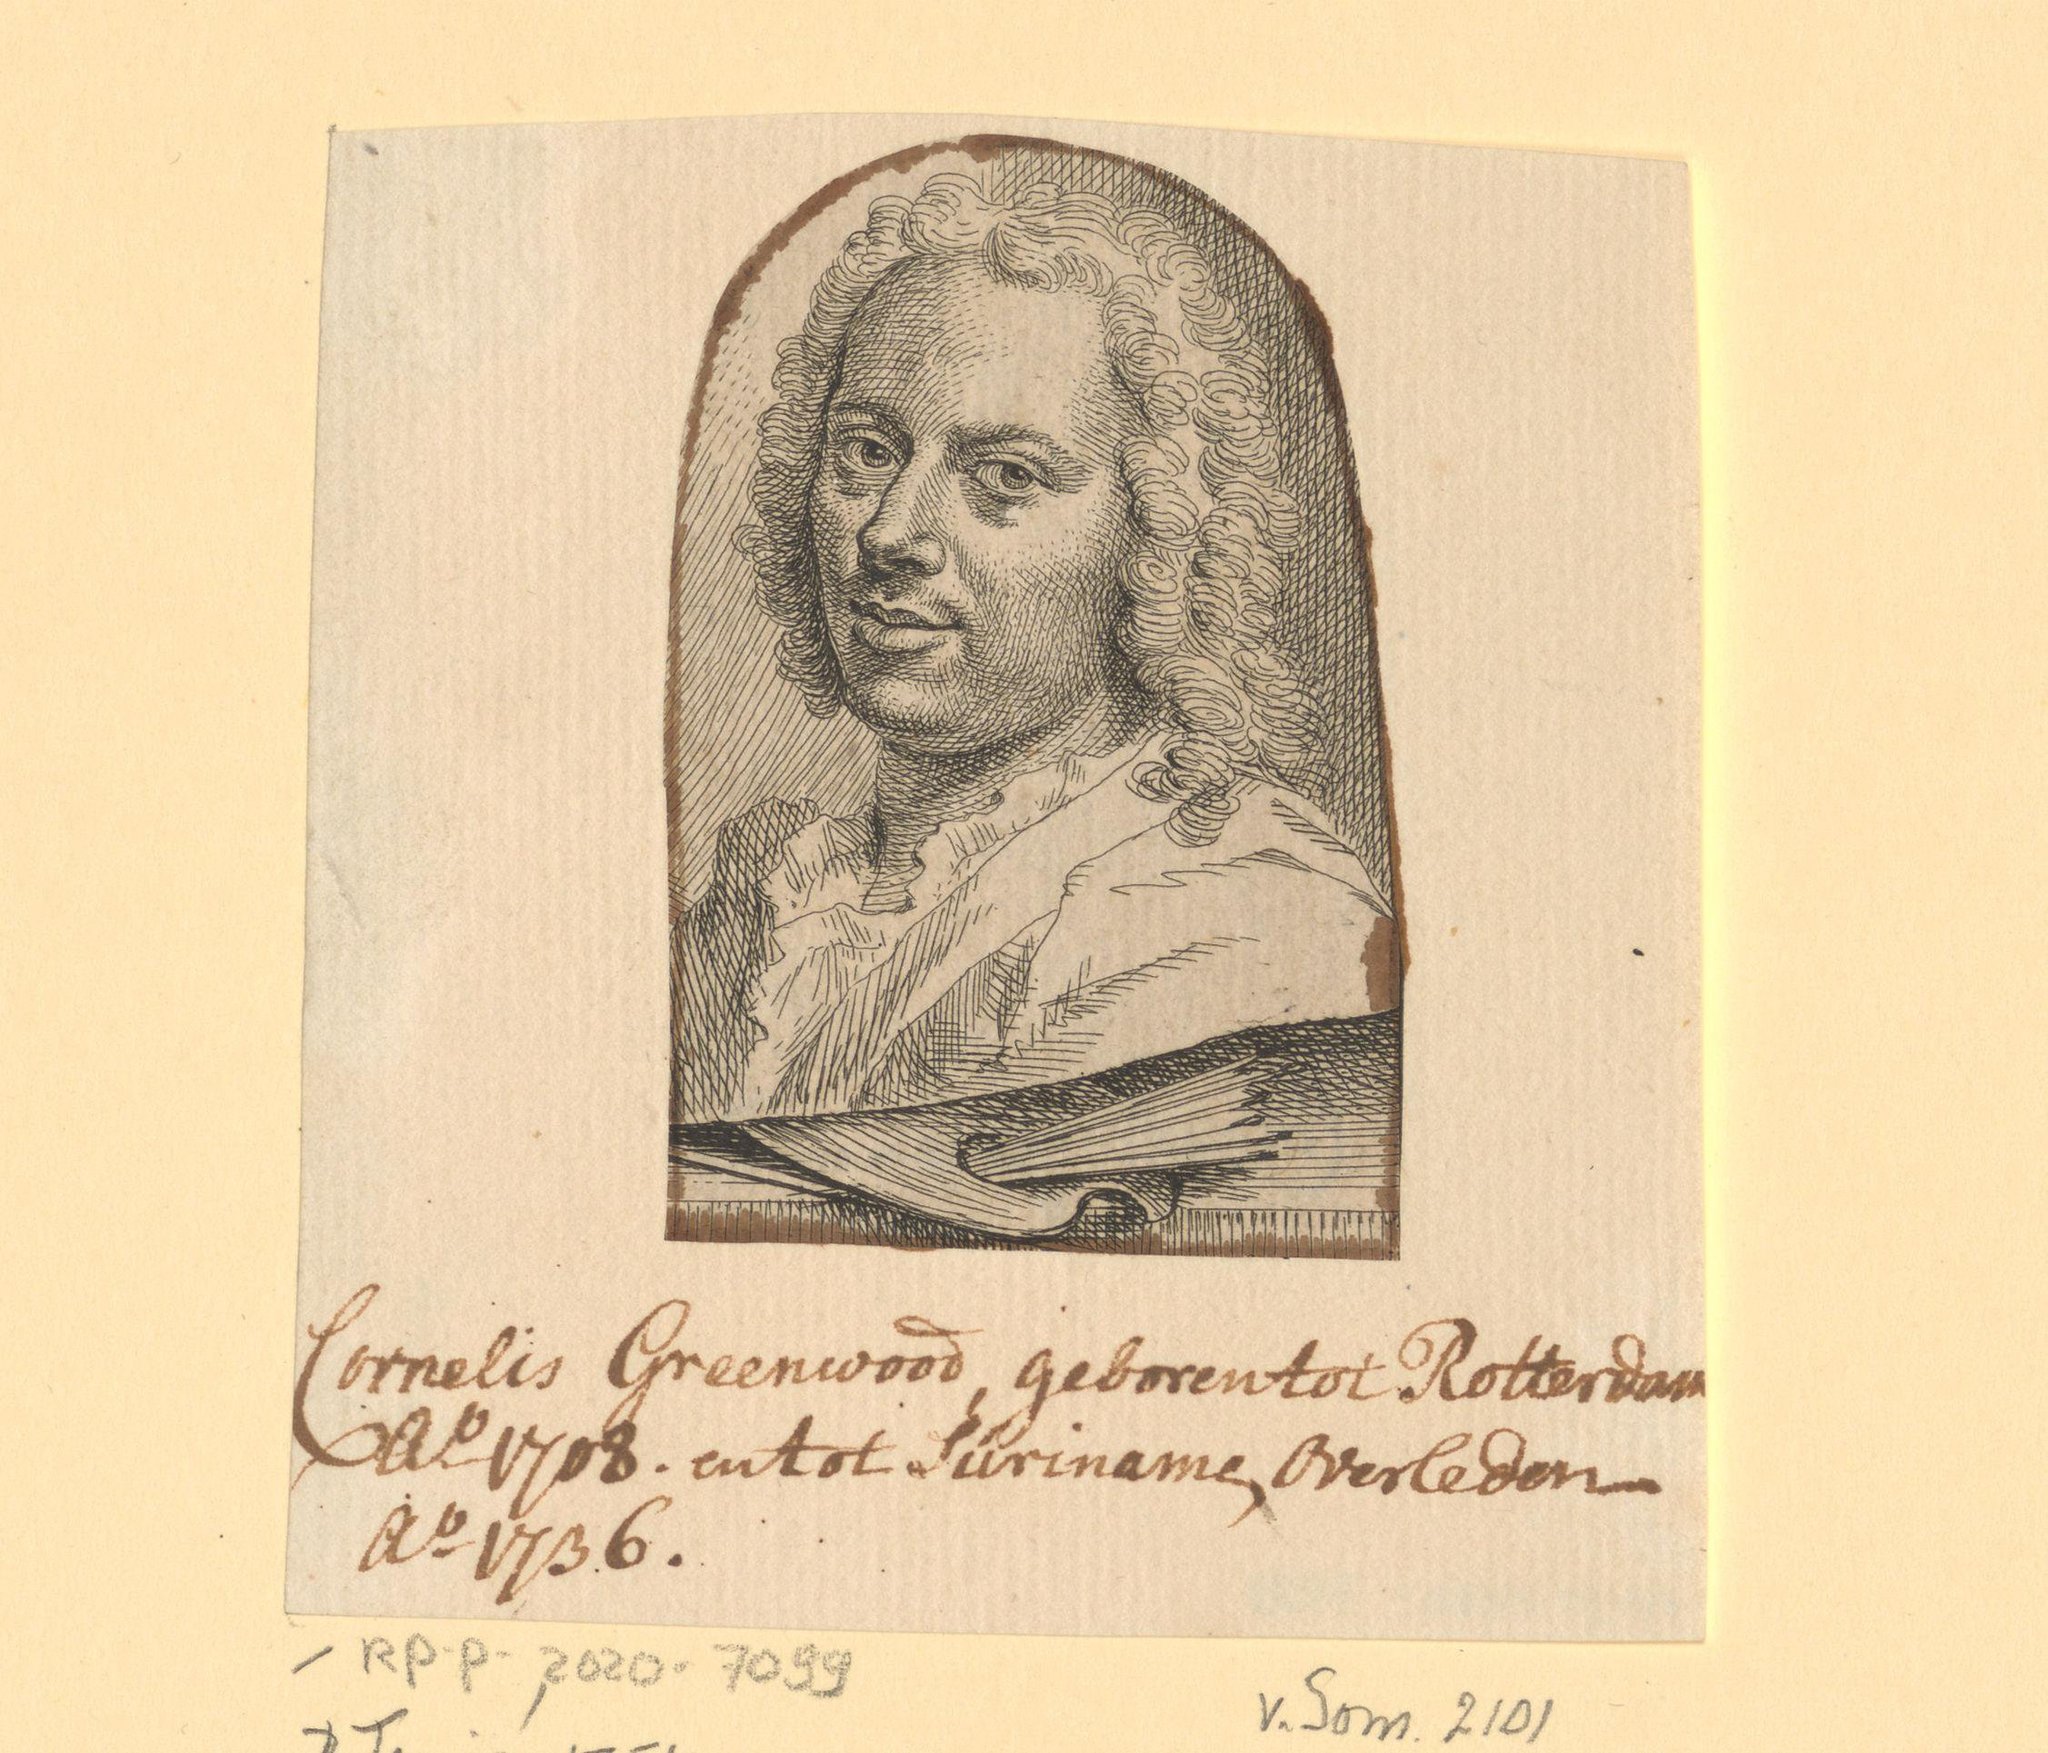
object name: print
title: Portret van Cornelis Greenwood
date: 1751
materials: ink, paper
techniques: engraving, pen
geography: the hague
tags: rotterdam, suriname, painter, draughtsman, historical persons, portrait, self-portrait of painter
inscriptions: collector's mark: Lugt 2228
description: Prent uit: Gool, Johan van. De nieuwe schouburg der Nederlantsche kunstschilders en schilderessen. Den Haag: s.n., 1751, dl. 2, p. 212.